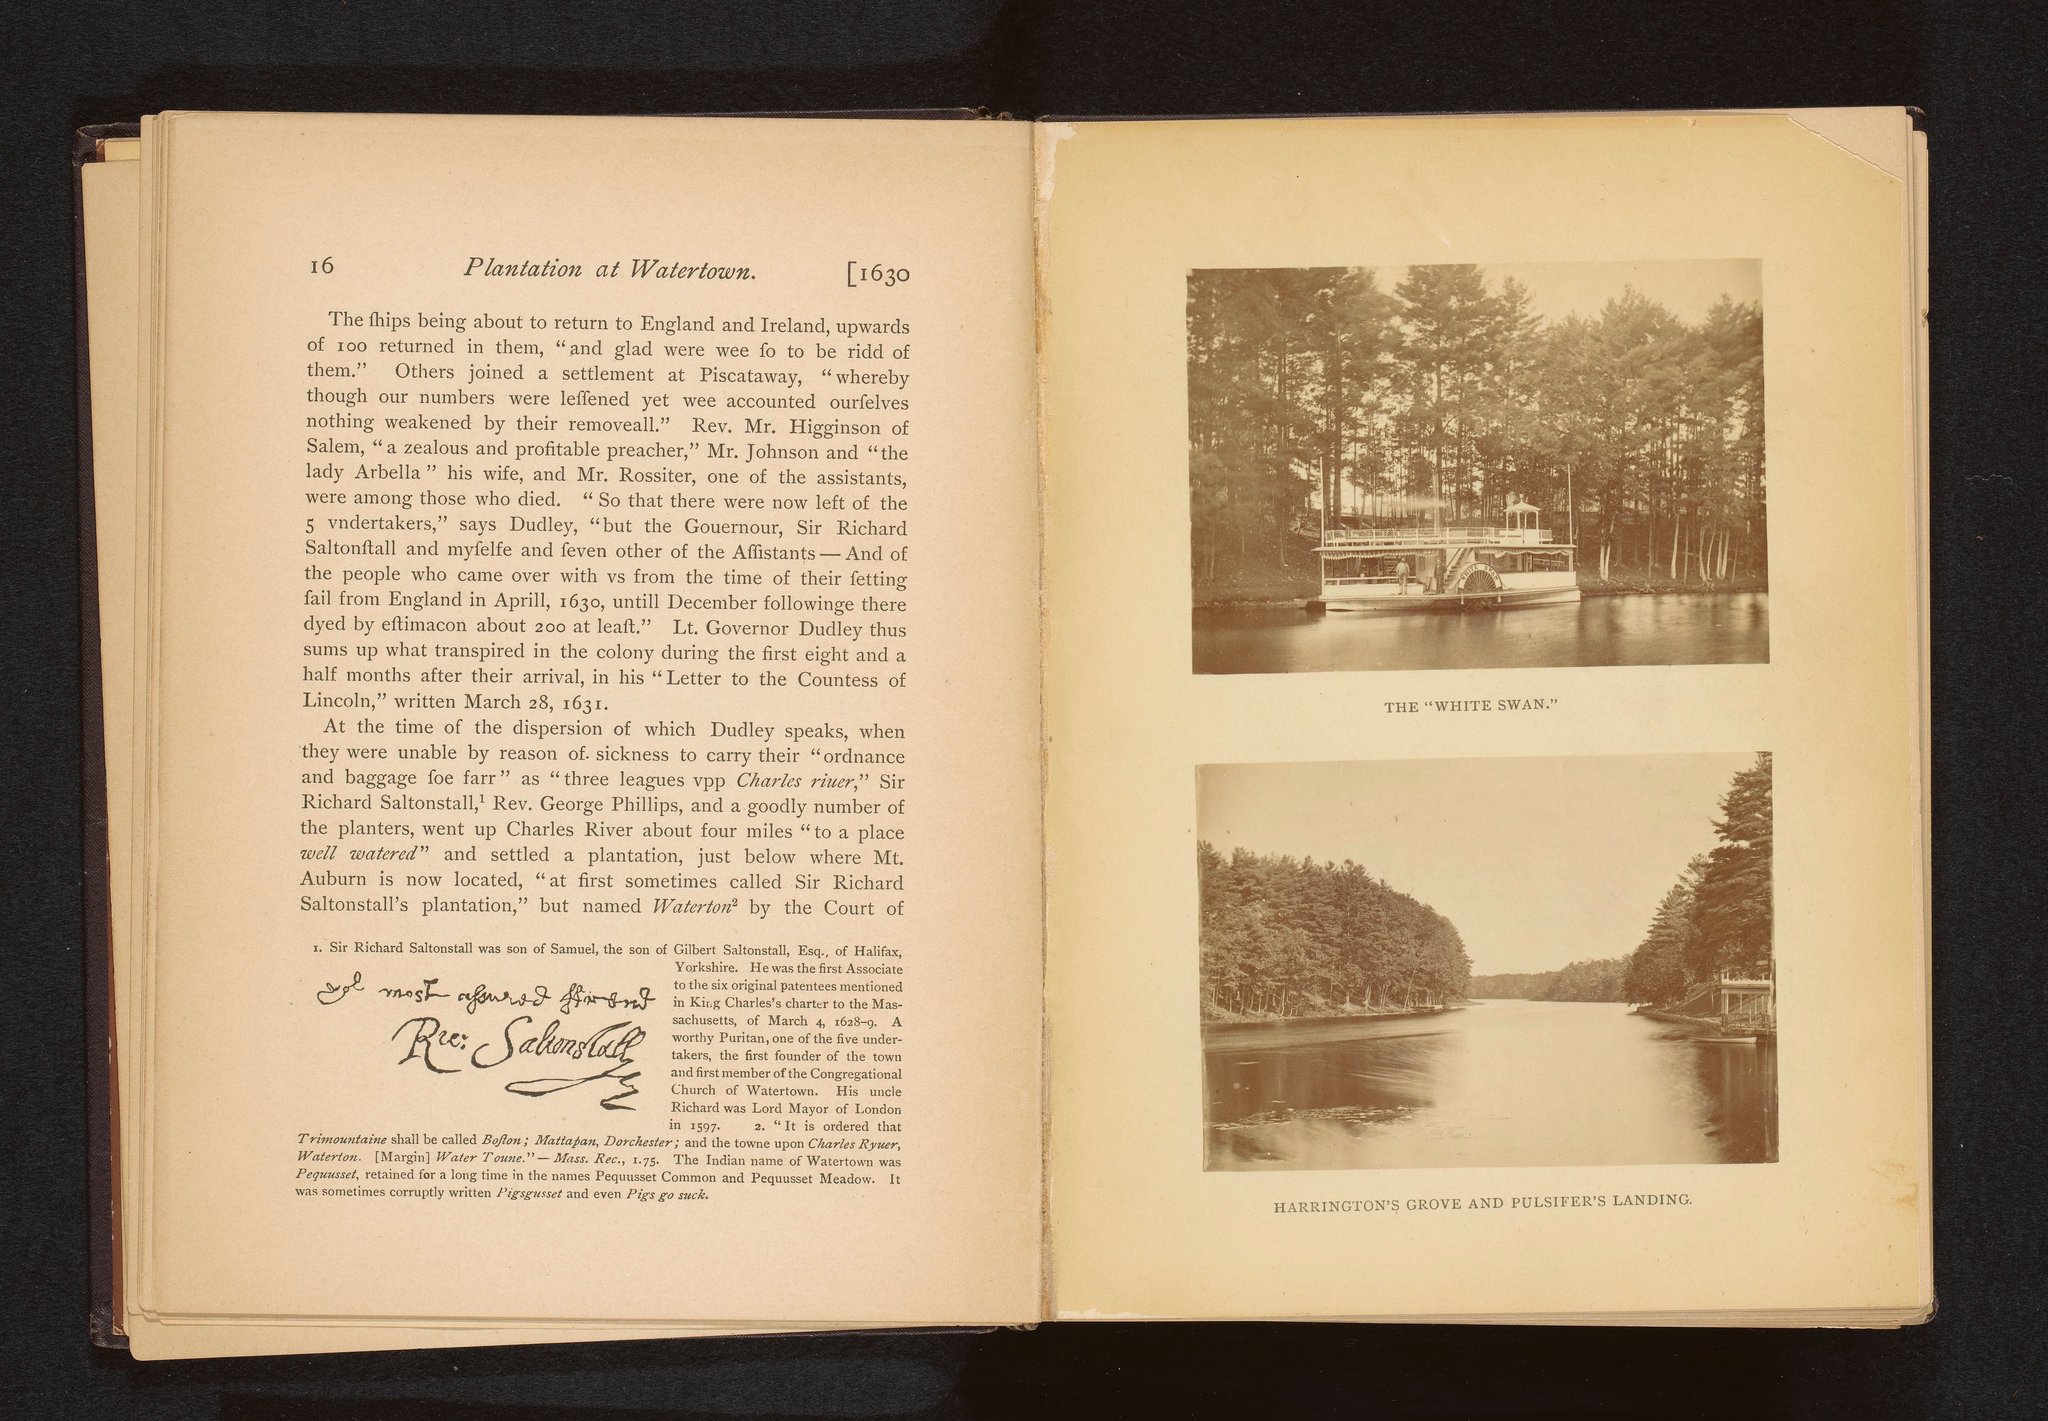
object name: photograph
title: Gezicht op een veerboot op een rivier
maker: thomas r. lewis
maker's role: publisher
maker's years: 1845-1901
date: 1874-1879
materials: photographic support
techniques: albumen print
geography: waltham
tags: ferry